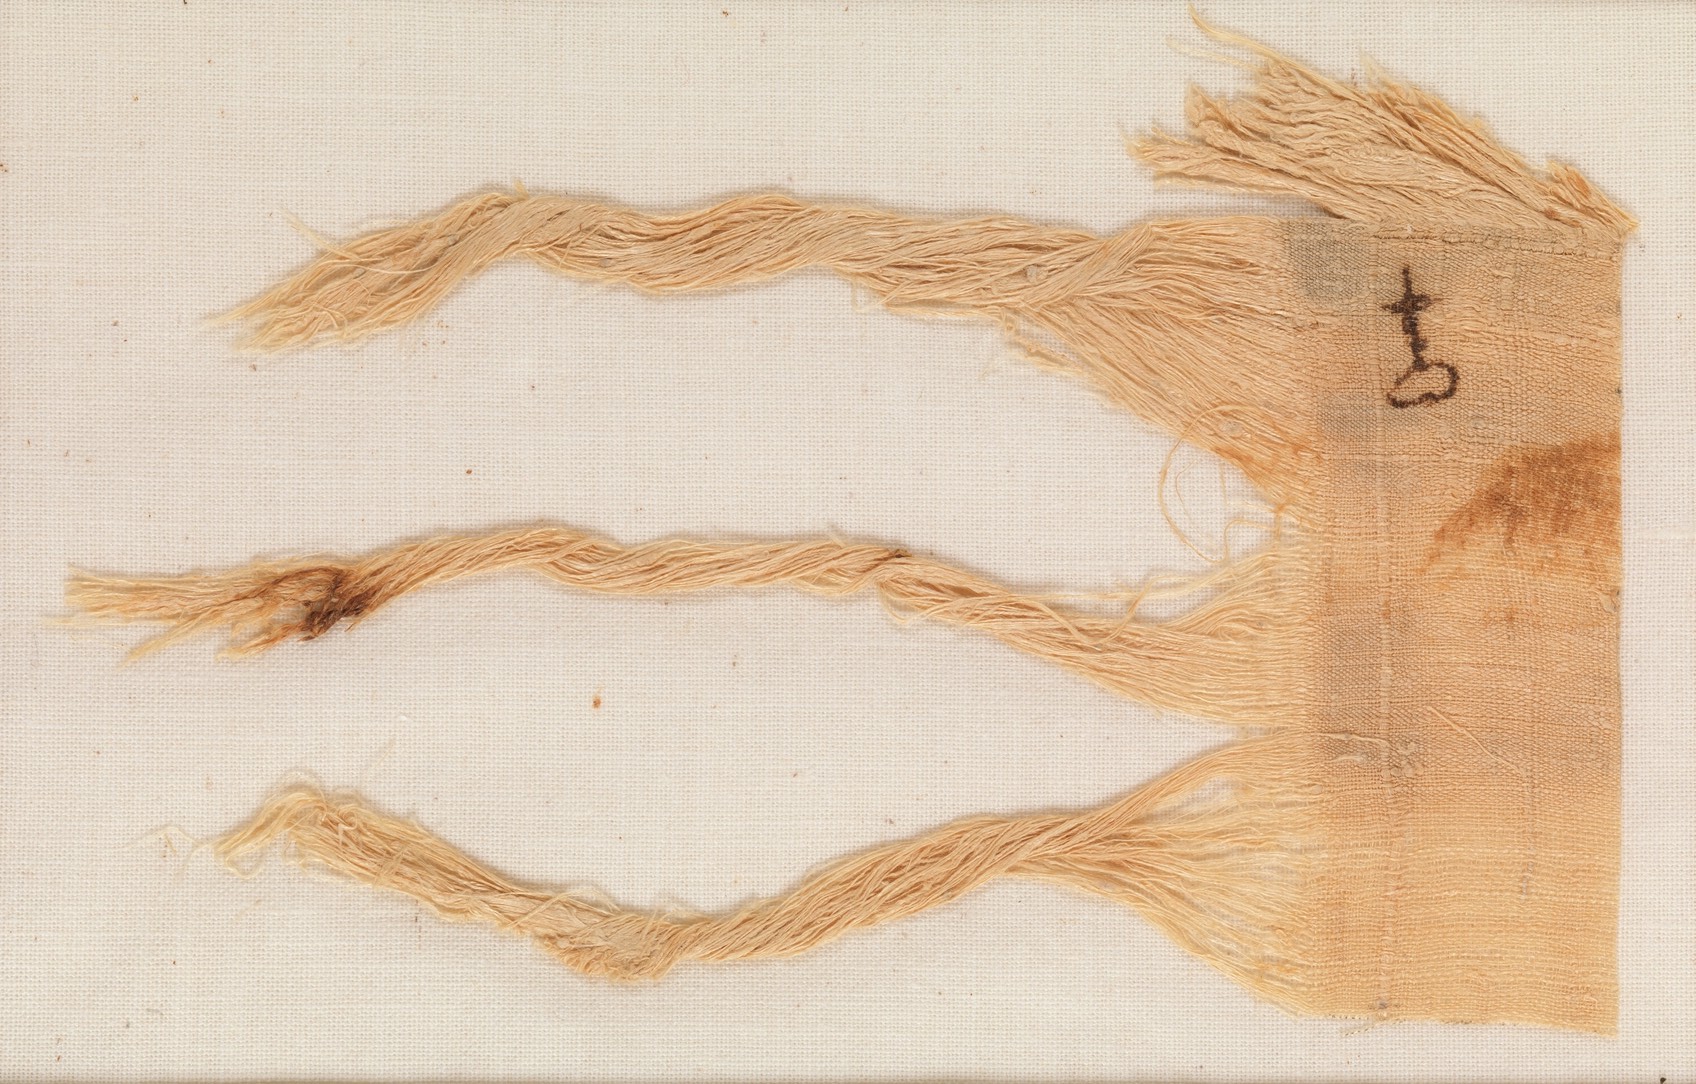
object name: linen mark, wah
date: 1981-1975 BCE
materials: linen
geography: egypt